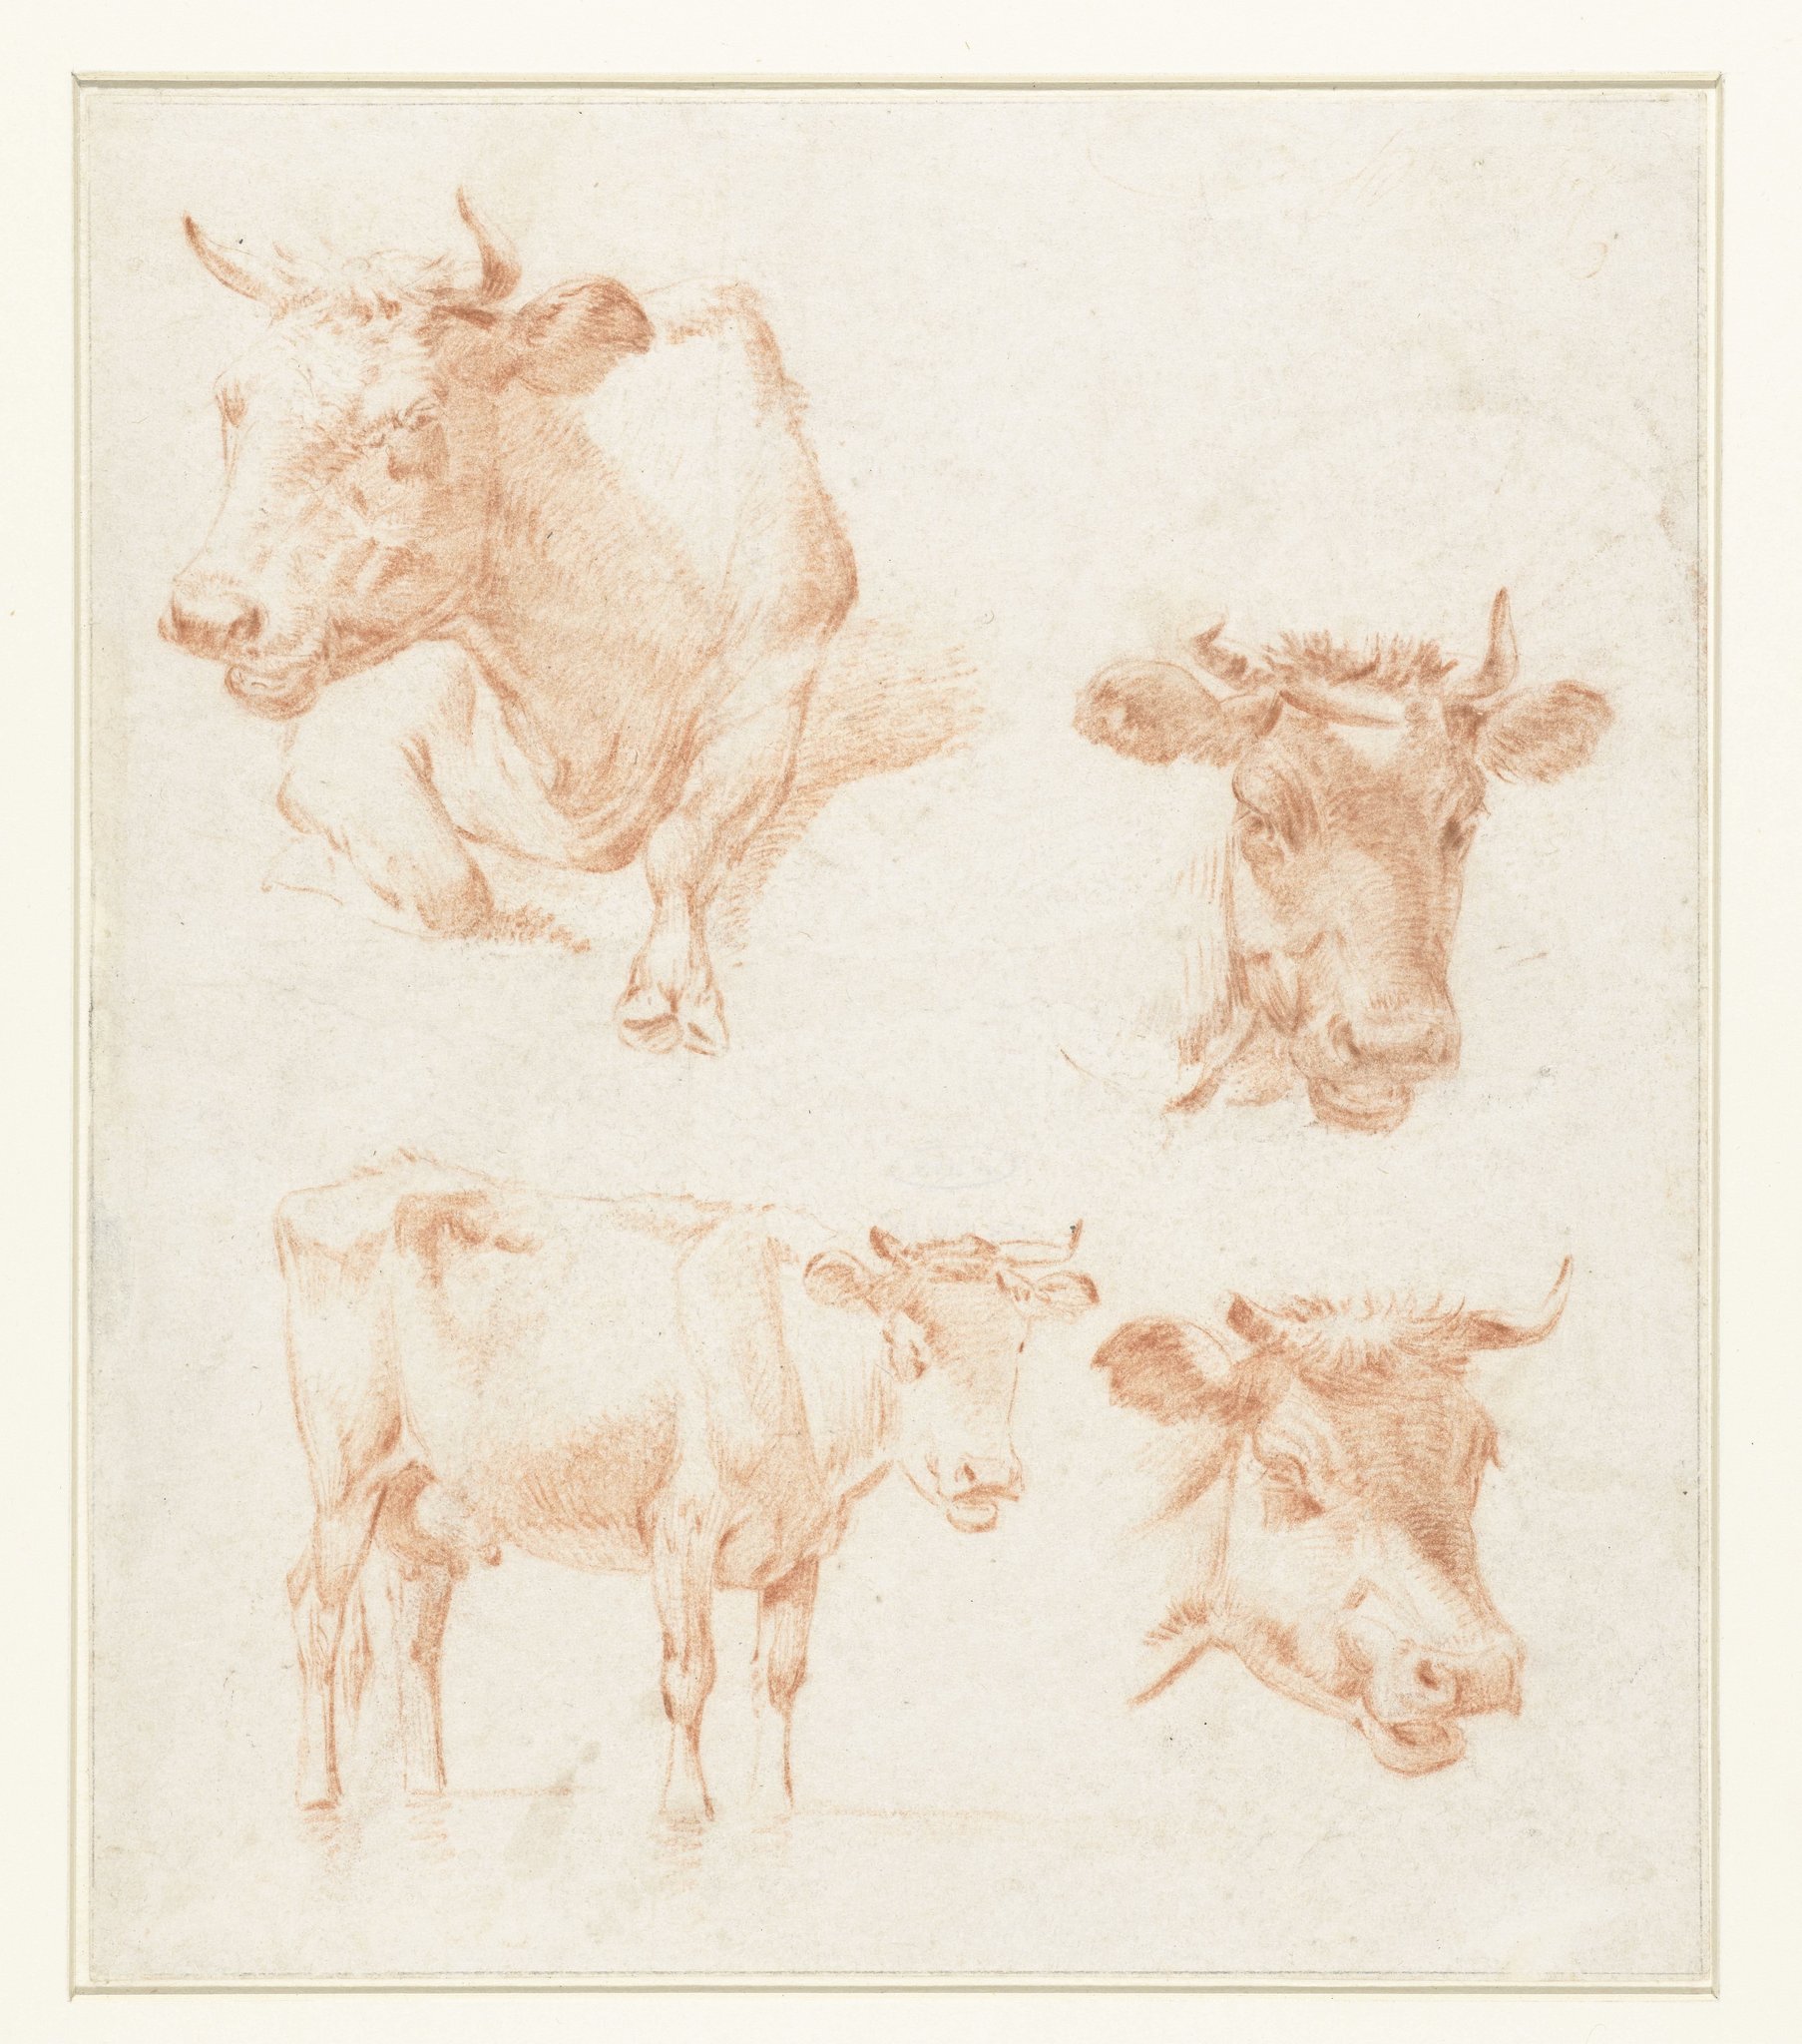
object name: drawing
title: Vier koeien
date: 1775-1833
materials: chalk, paper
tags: cow